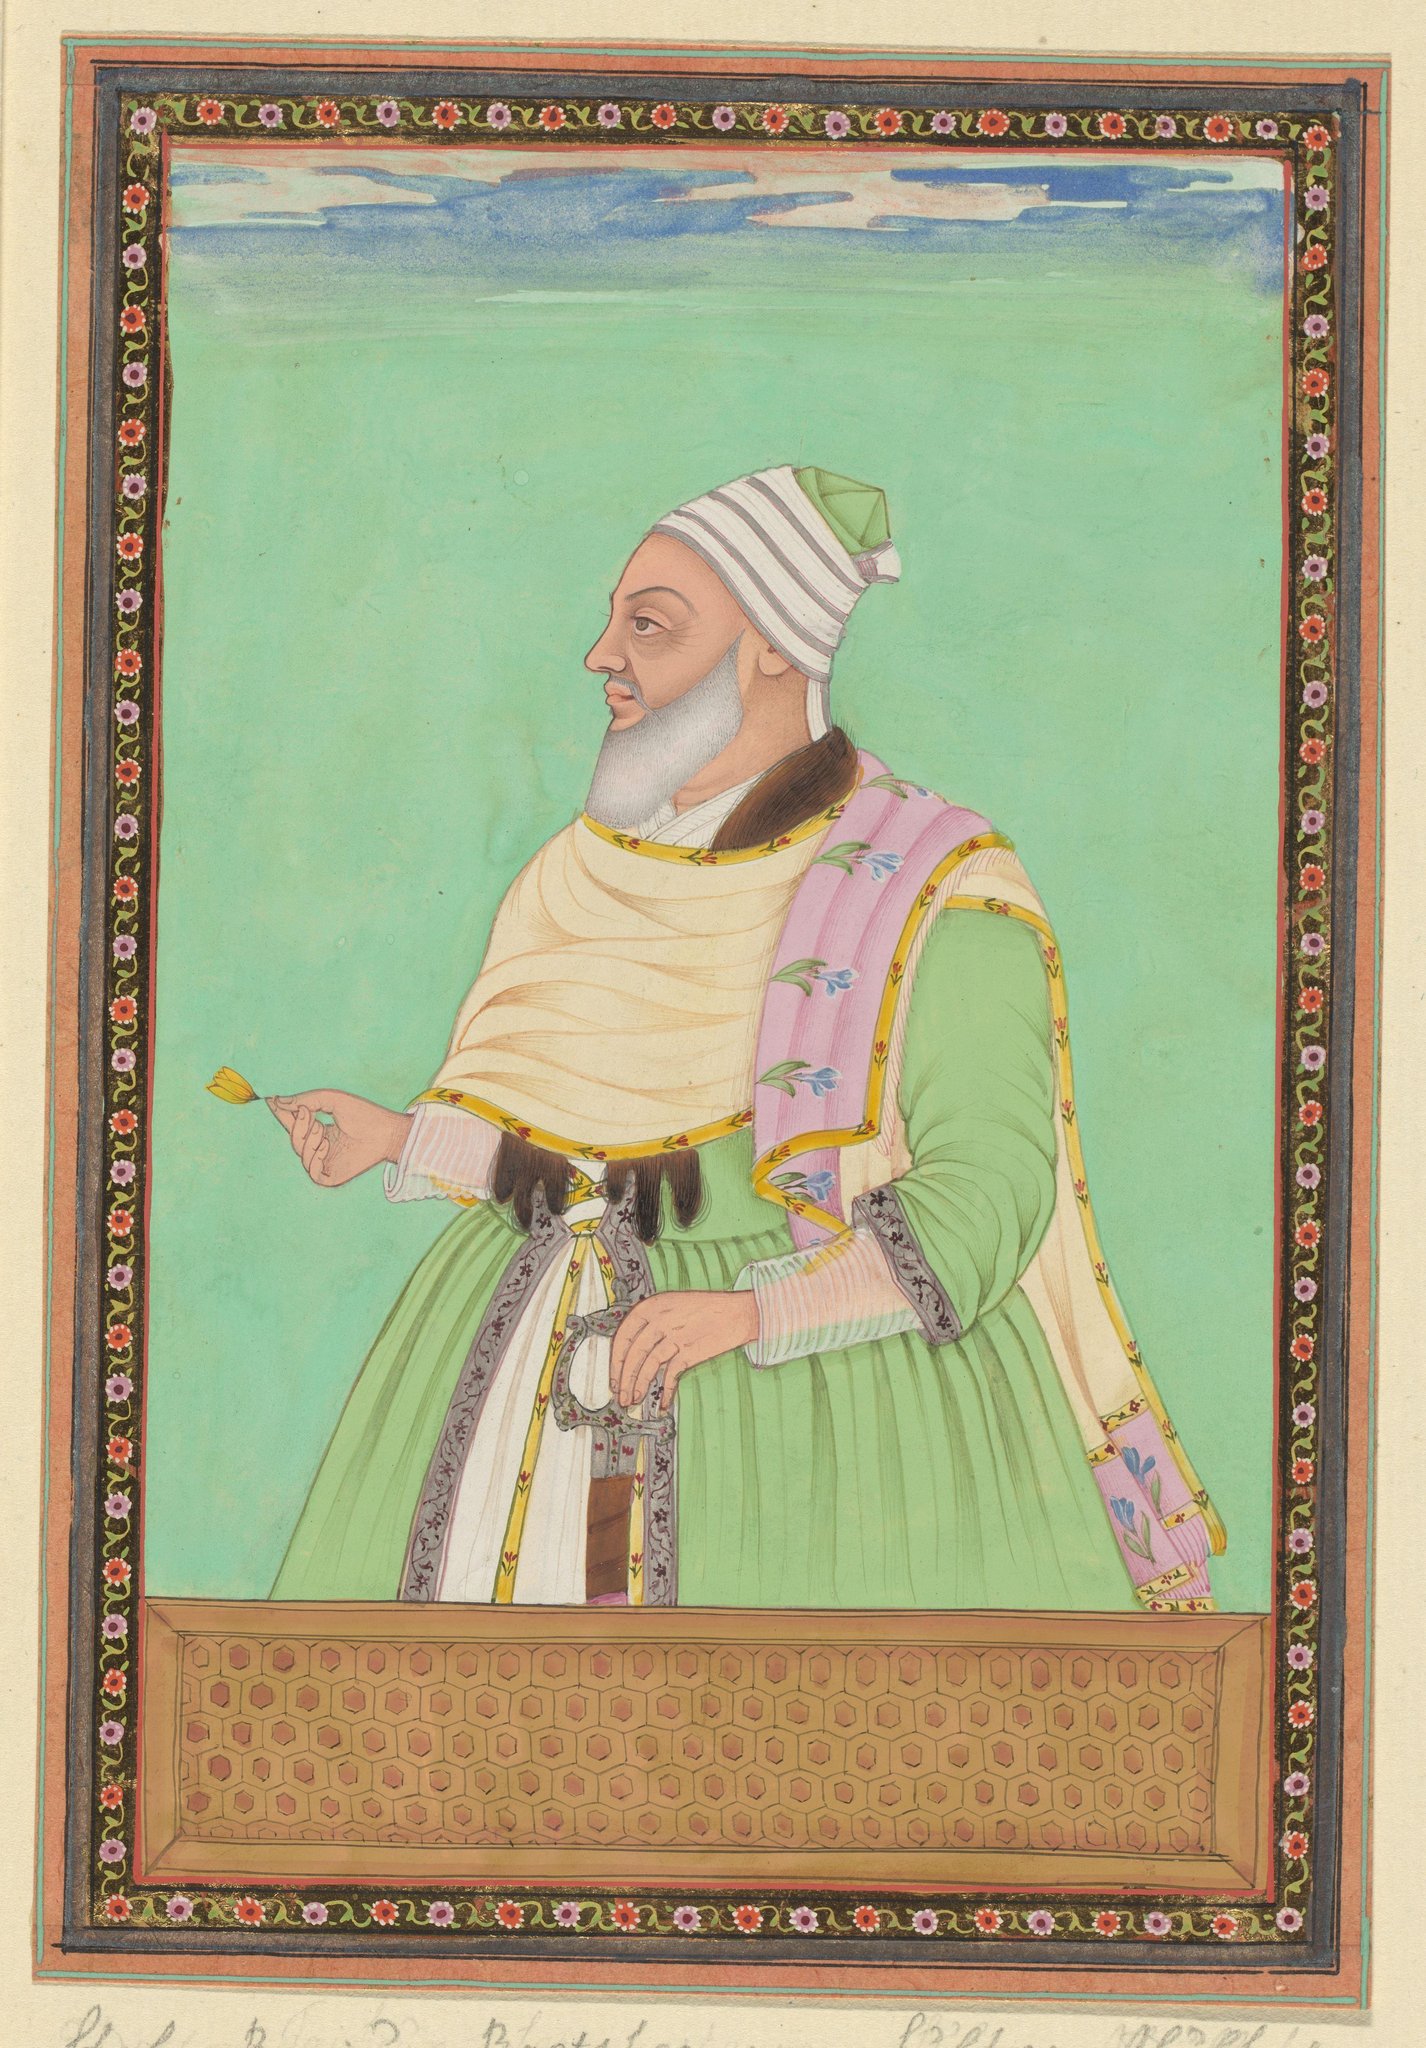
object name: indian miniature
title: Portret van Shah Raju, de geestelijke leidsman (pir) van Sultan Abul Hasan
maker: Anonymous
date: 1686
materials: paint, gold leaf, gouache, paper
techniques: brush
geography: golkonda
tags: amsterdam, mayor, nicolaes cornelisz. witsen, historical person (...) - historical person (...) portrayed alone, ruler, sovereign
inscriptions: annotation: ‘Stah Ragiou, Raetsheer van Sultan Abulhasan’, collector's mark: Lugt 1838, collector's mark: Lugt 240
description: Shah Raju is tot aan zijn heupen afgebeeld, naar links gewend, zijn linkter hand op zijn zwaard, in zijn rechter hand een bloem. Blad 30 in het `Witsen-Album', met 49 Indiase miniaturen van vorsten. Boven het portret een stukje papier met de naam in het Perzisch. Onder het portret een stukje papier met de naam in het Portugees.